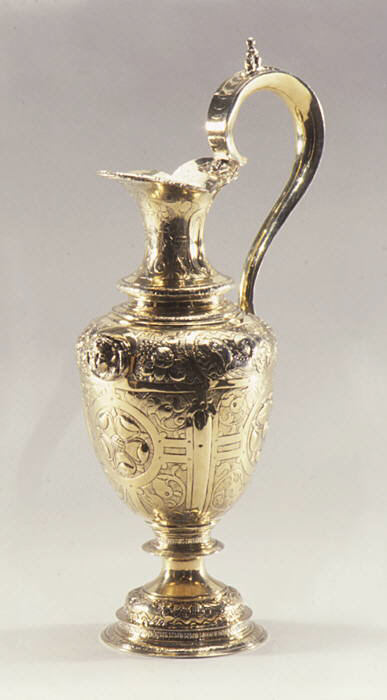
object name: ewer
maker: symon owen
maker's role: maker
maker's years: 1595-1624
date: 1610-1611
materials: silver gilt